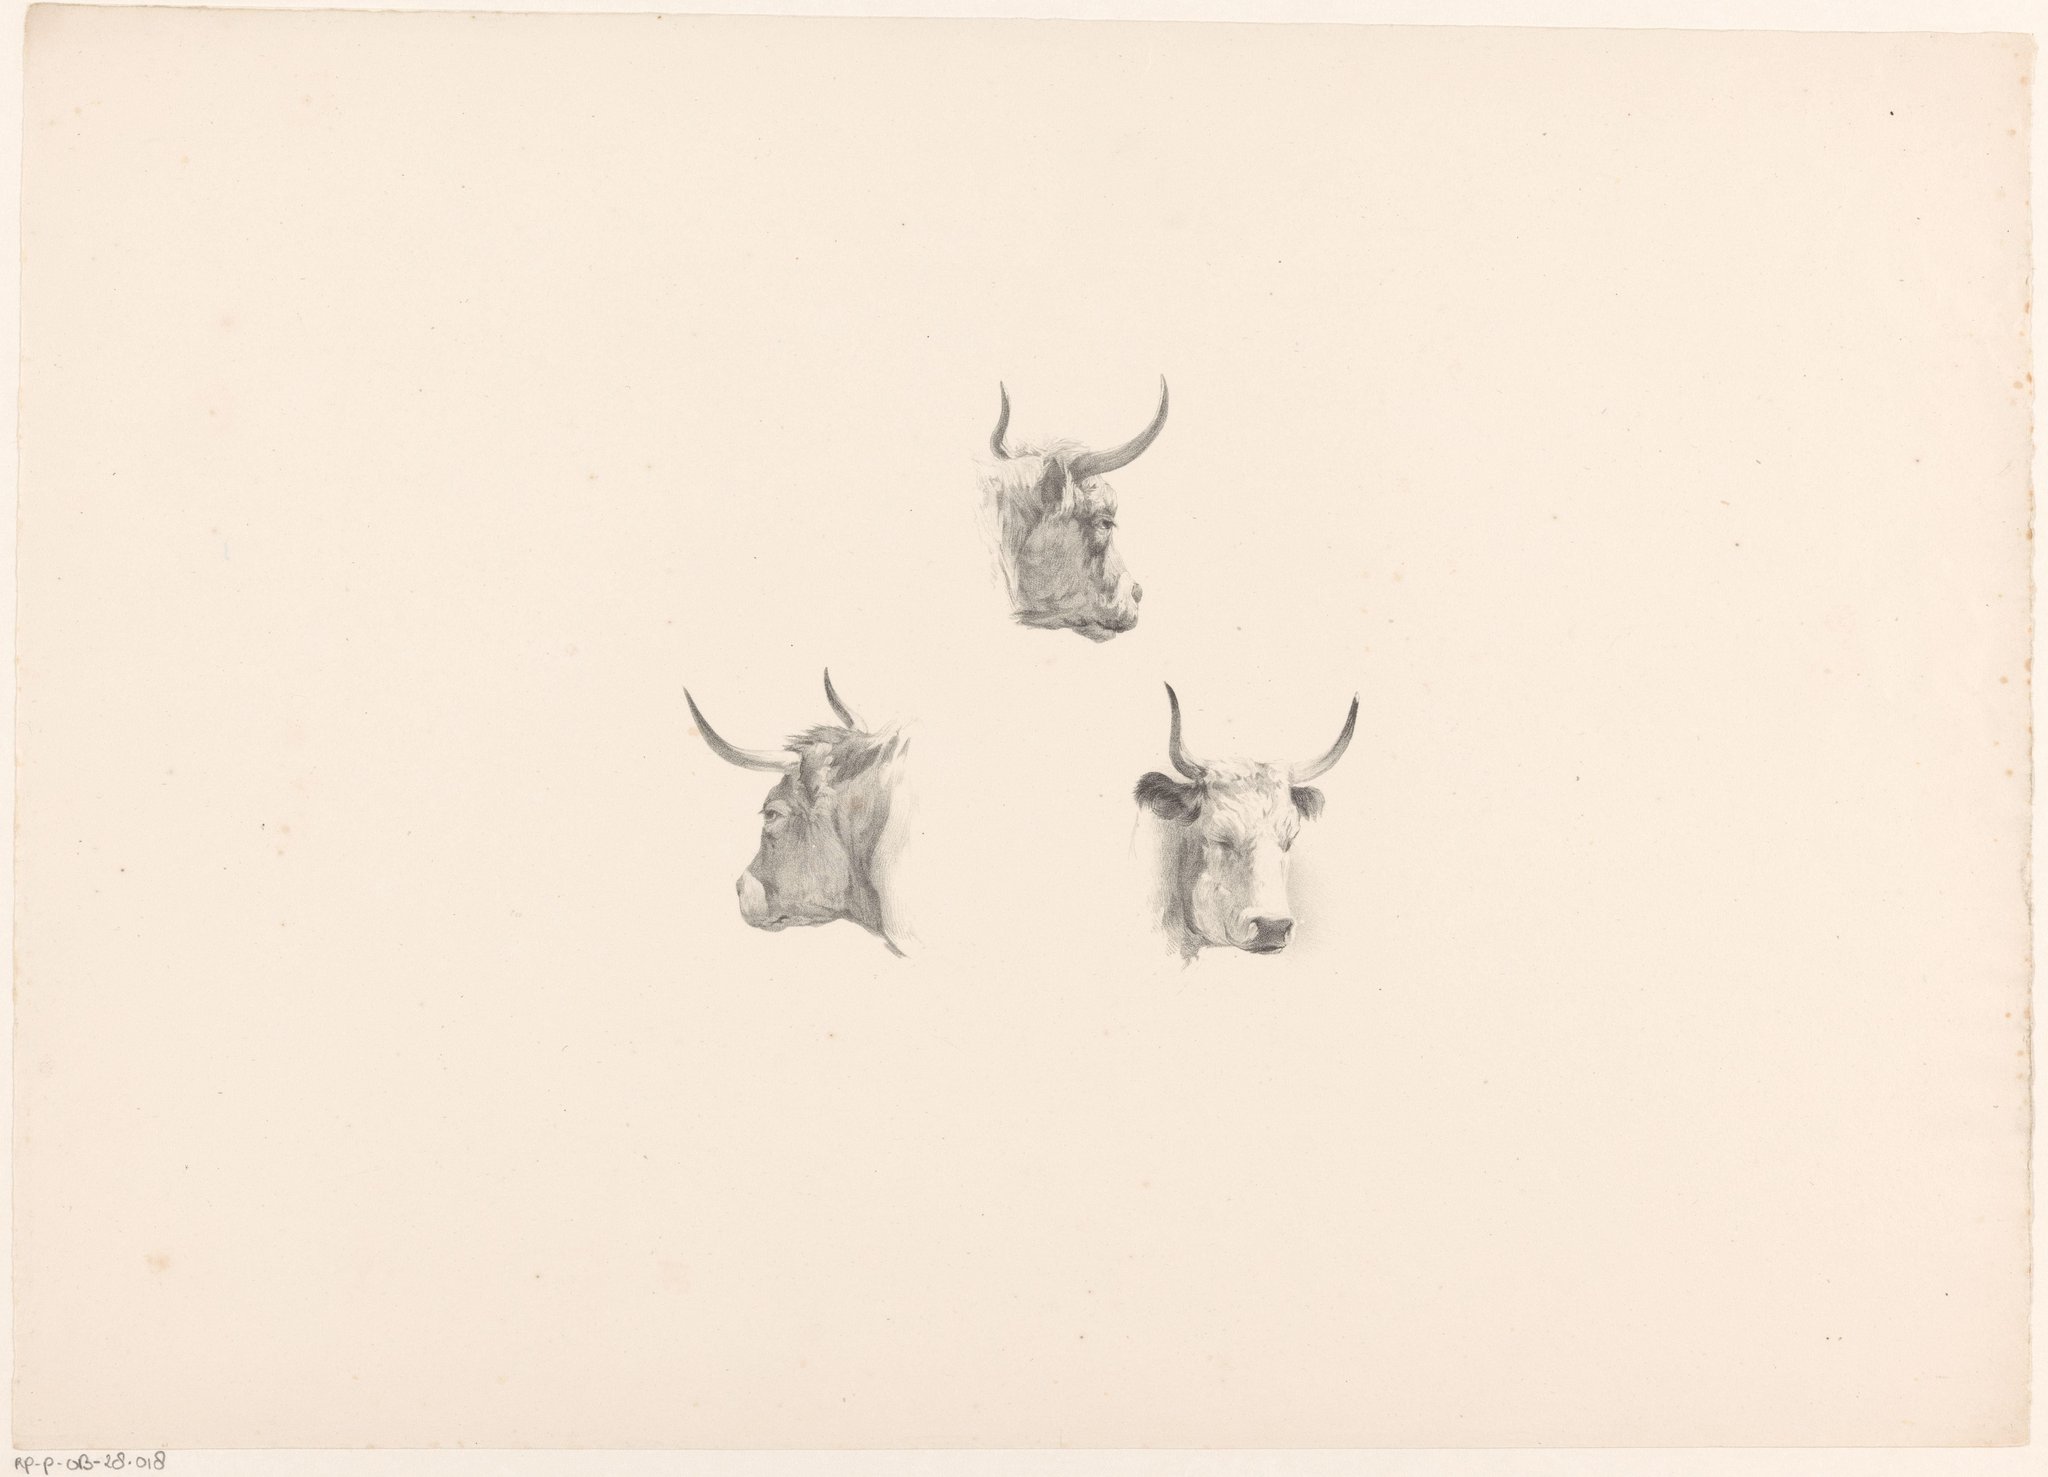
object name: print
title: Drie ossekoppen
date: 1820-1833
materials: paper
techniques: lithograph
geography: amsterdam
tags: ox (+ head of an animal)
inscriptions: collector's mark: Lugt 2228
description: Deze prent maakte mogelijk deel uit van de serie: 'Origineele Beesten Studien op Steen getekend na Potter, Van de Velde, Berghem, en andere Oude Hollandsche Meesters' door J. A. Daiwaille.